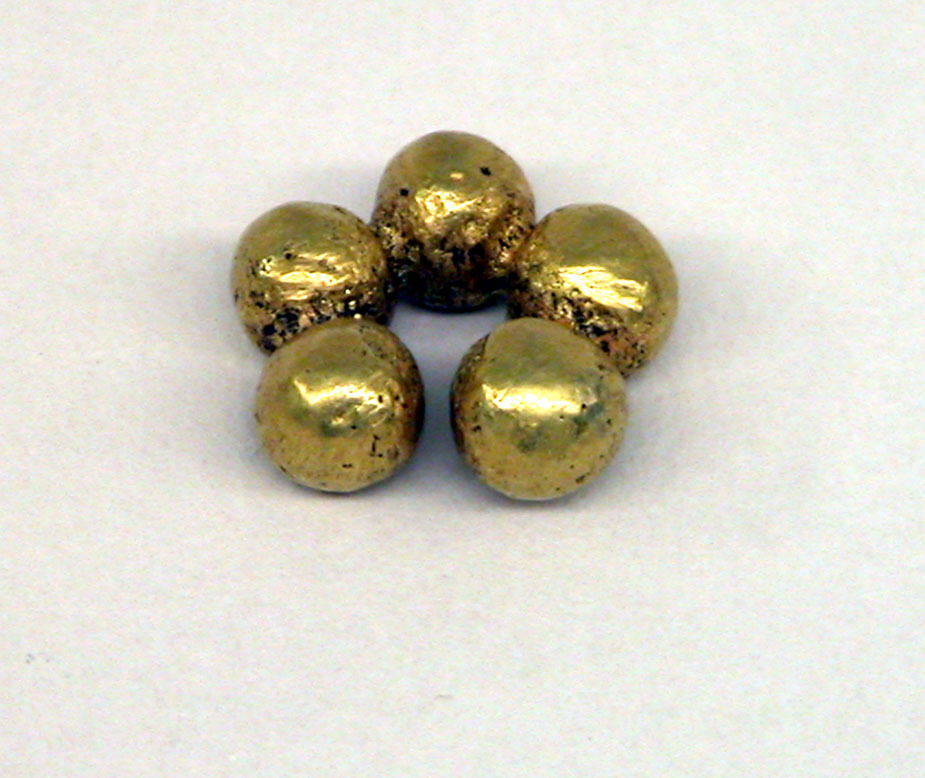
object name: ear ornament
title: Pair of Ear Ornaments Composed of Beads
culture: indonesian, javanese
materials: gold